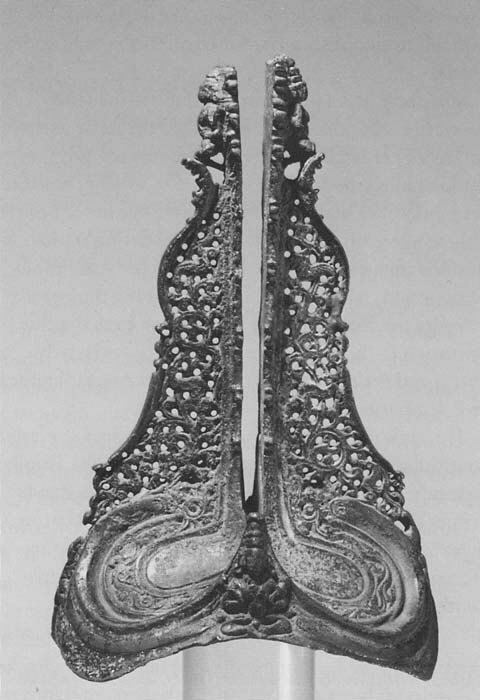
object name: dance wand hilt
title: Hilt, Perhaps from a Dance Wand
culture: indian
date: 1401-1500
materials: bronze